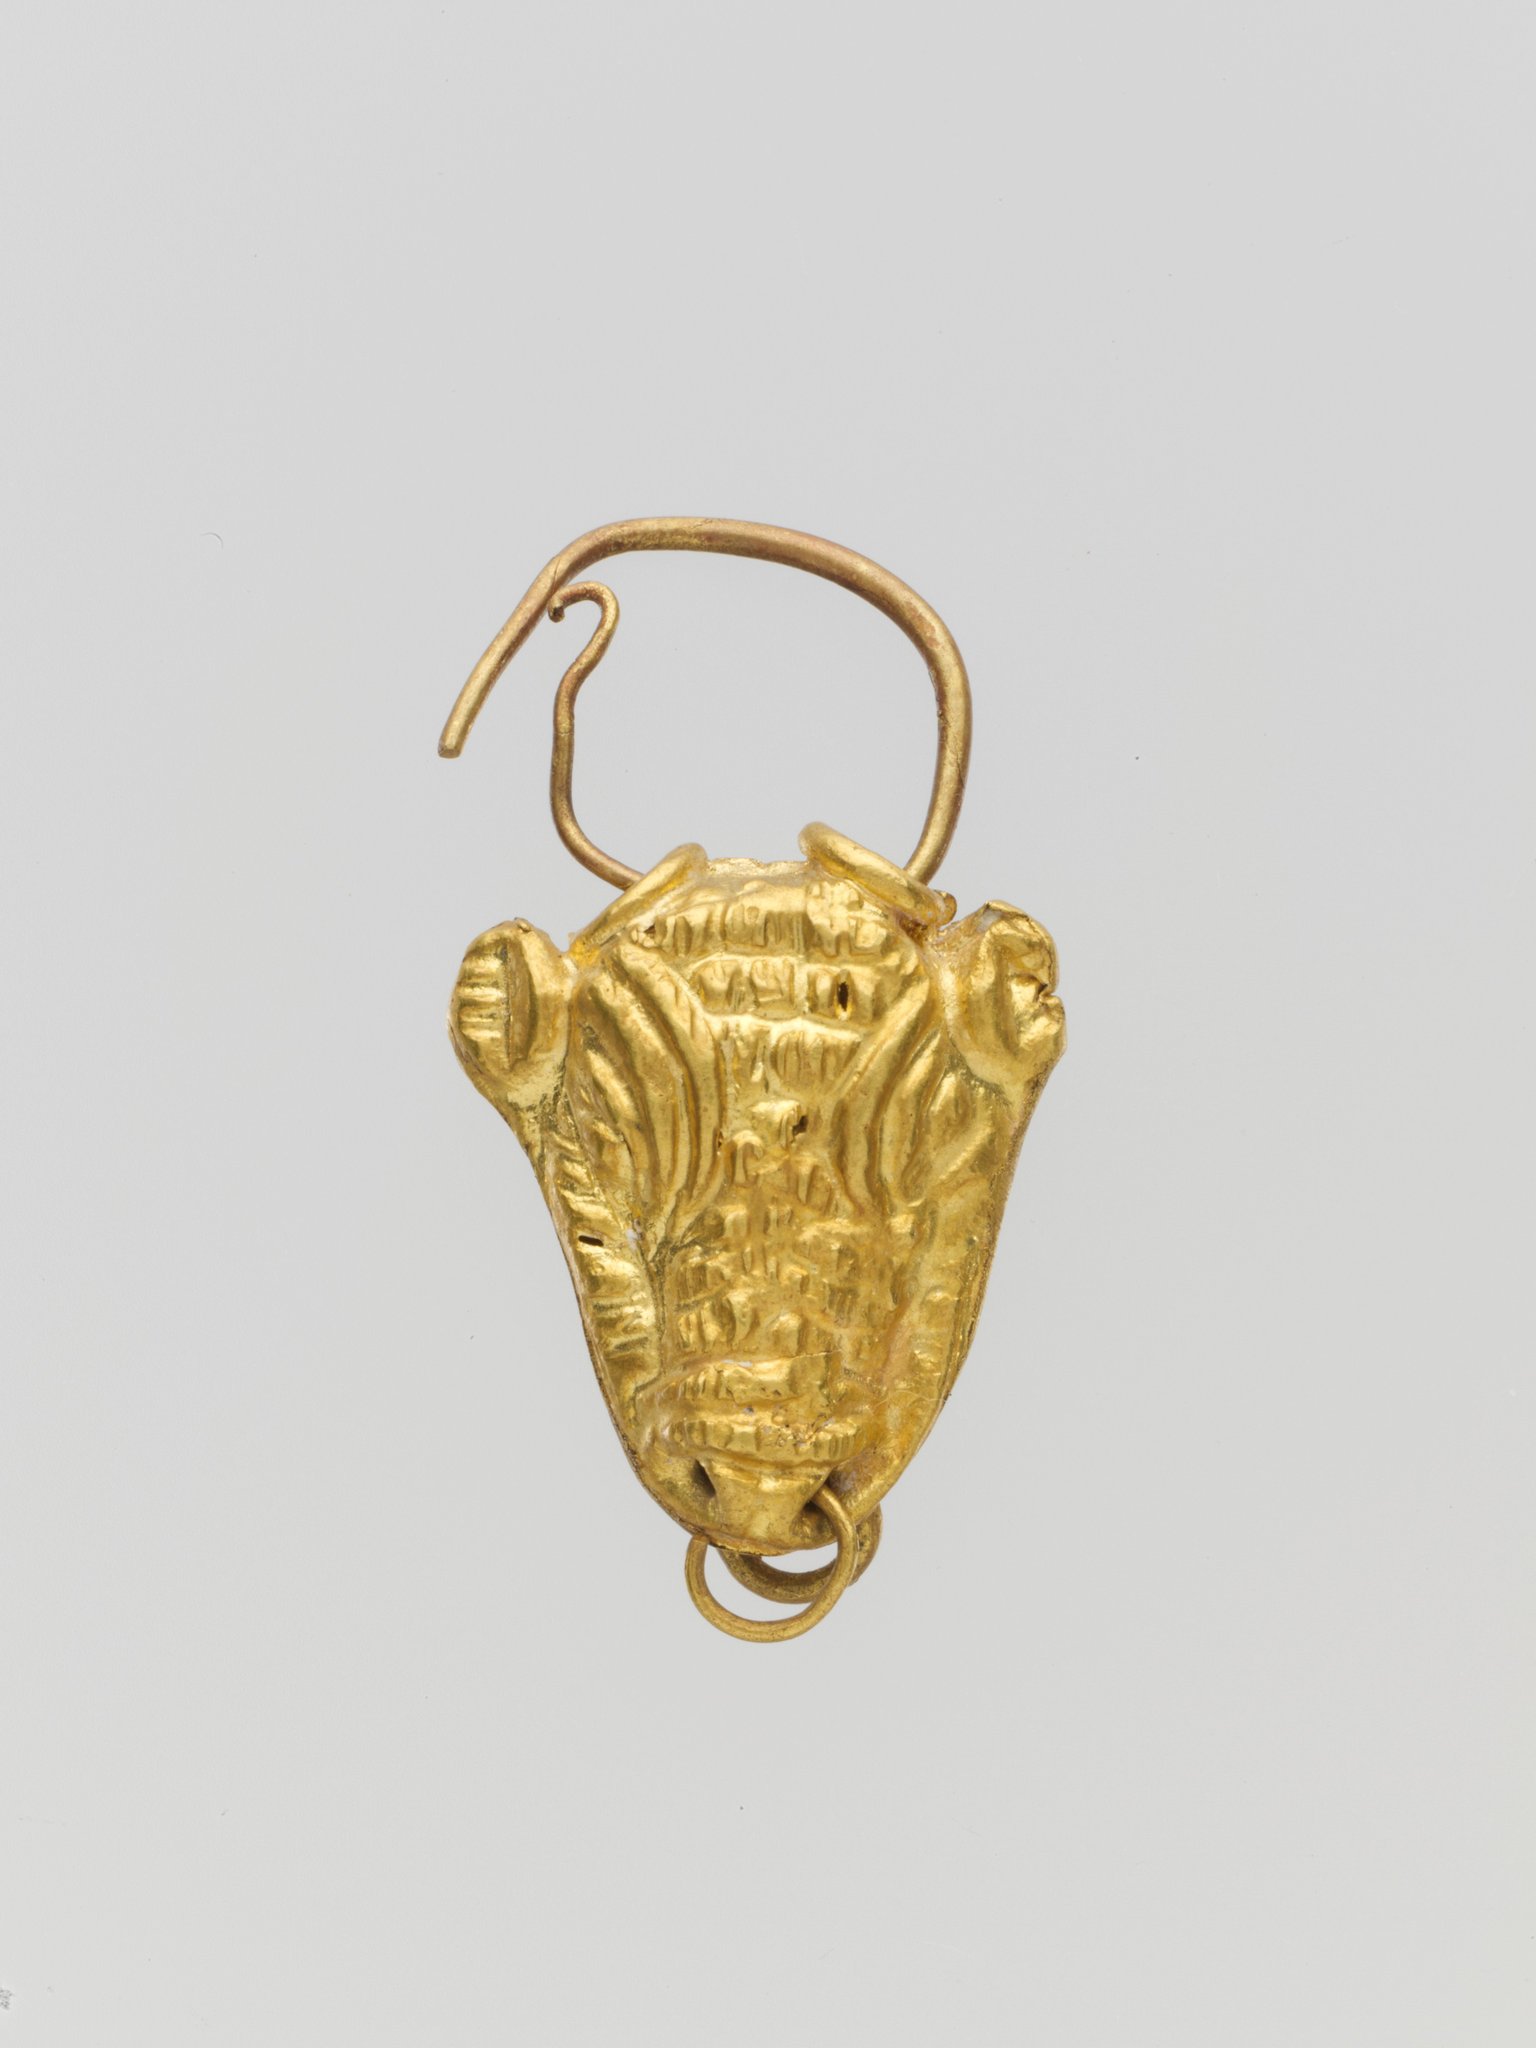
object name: earring with head of bull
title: Gold pendant in the form of a bull's head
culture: cypriot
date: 1400-1050 BCE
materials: gold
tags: bulls